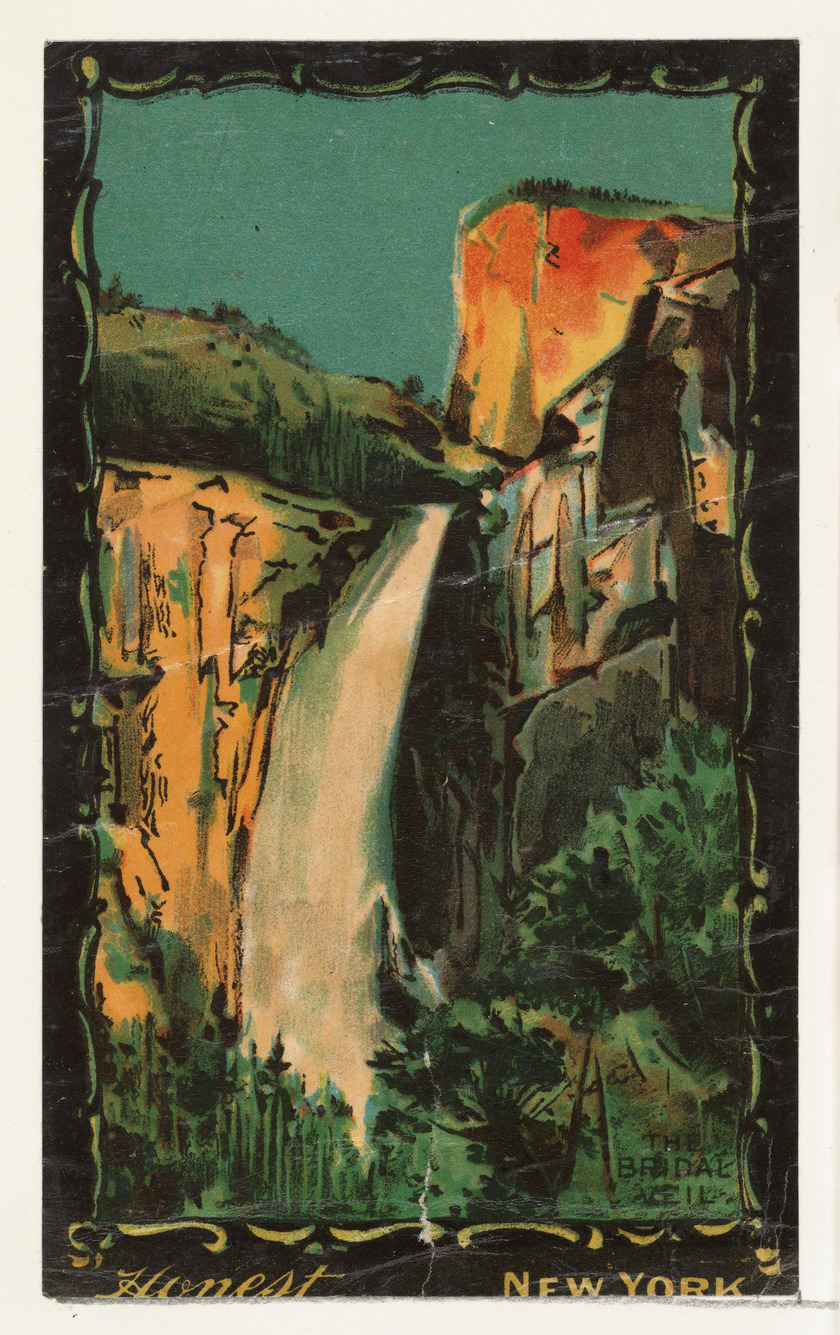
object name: print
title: The Bridal Veil, from the Transparencies series (N137) issued by W. Duke, Sons & Co. to promote Honest Long Cut Tobacco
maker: w. duke, sons & co.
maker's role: publisher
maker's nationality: american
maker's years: 1870-1920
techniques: color lithograph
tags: waterfalls